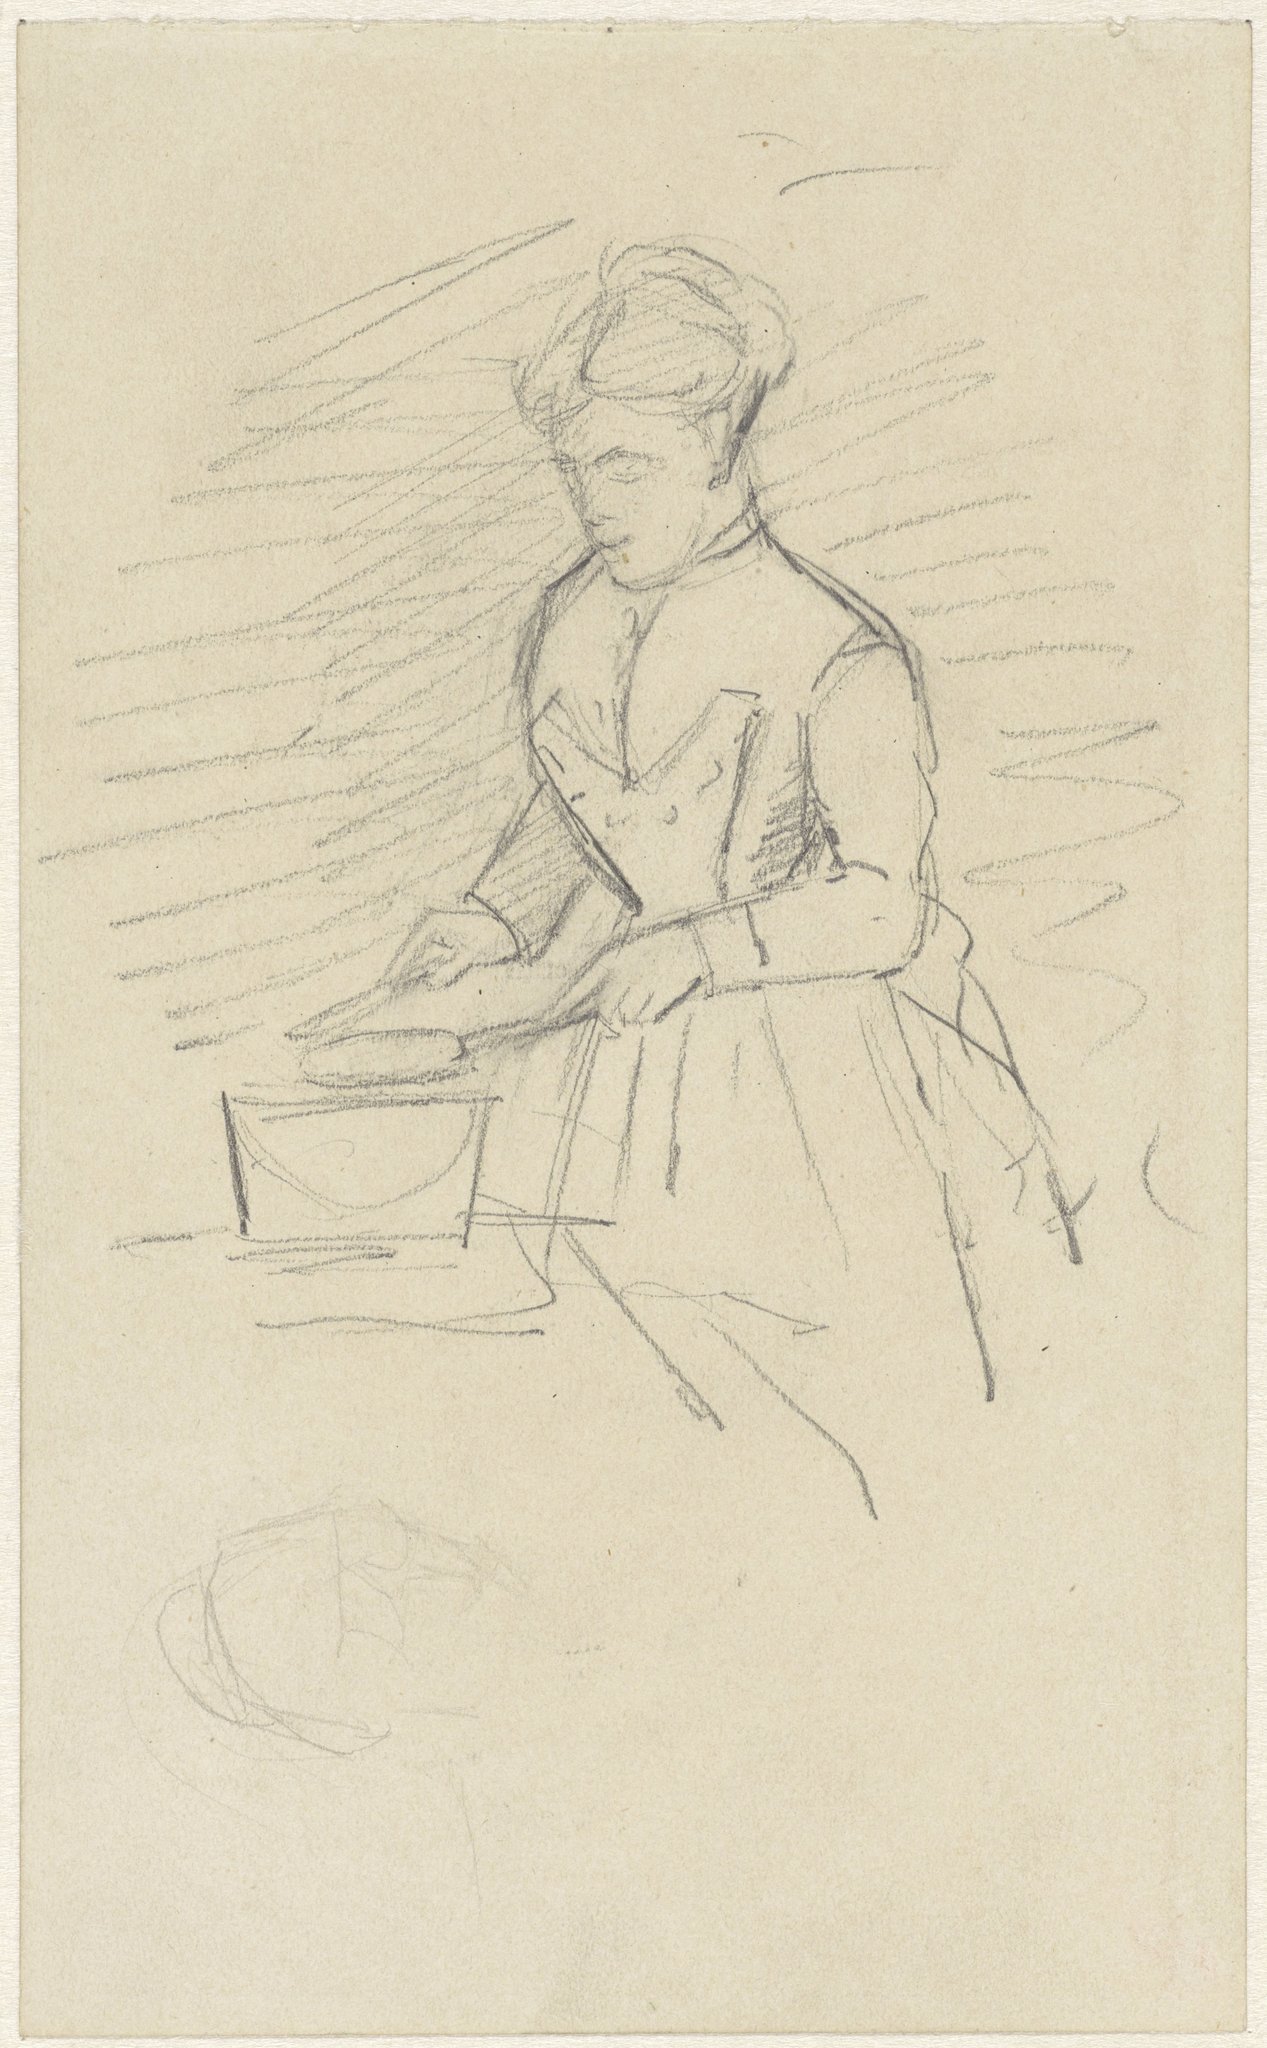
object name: drawing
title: Vrouw die aan het koken is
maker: jozef israëls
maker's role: draughtsman, painter, print maker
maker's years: 1824-1911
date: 1834-1911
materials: paper, pencil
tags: cooking food